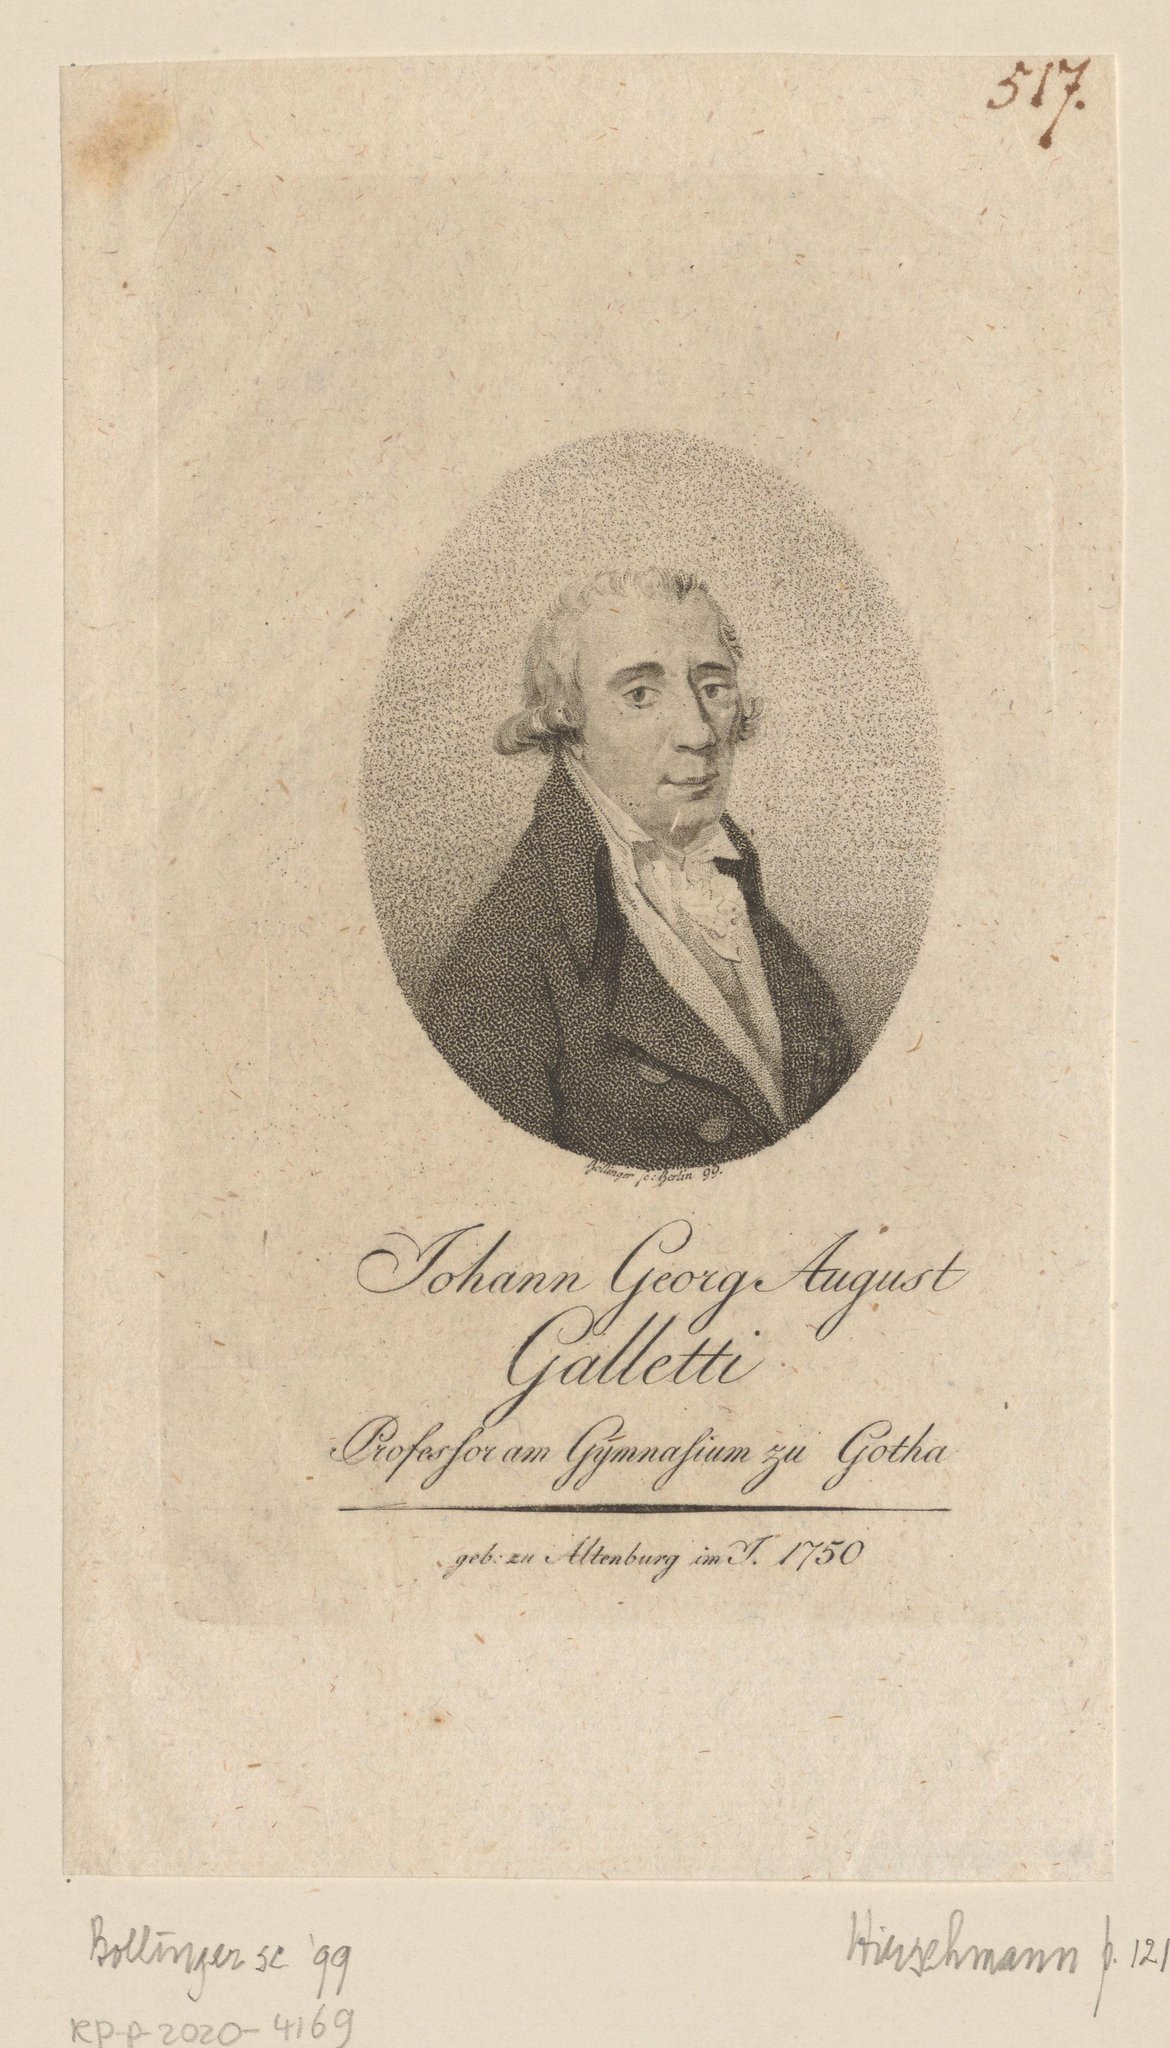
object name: print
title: Portret van Johann Georg August Galletti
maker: friedrich wilhelm bollinger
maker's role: print maker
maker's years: 1777-1825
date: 1799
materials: paper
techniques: etching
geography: berlin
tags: historical persons, physician, doctor (+ portrait of scholar, scientist)